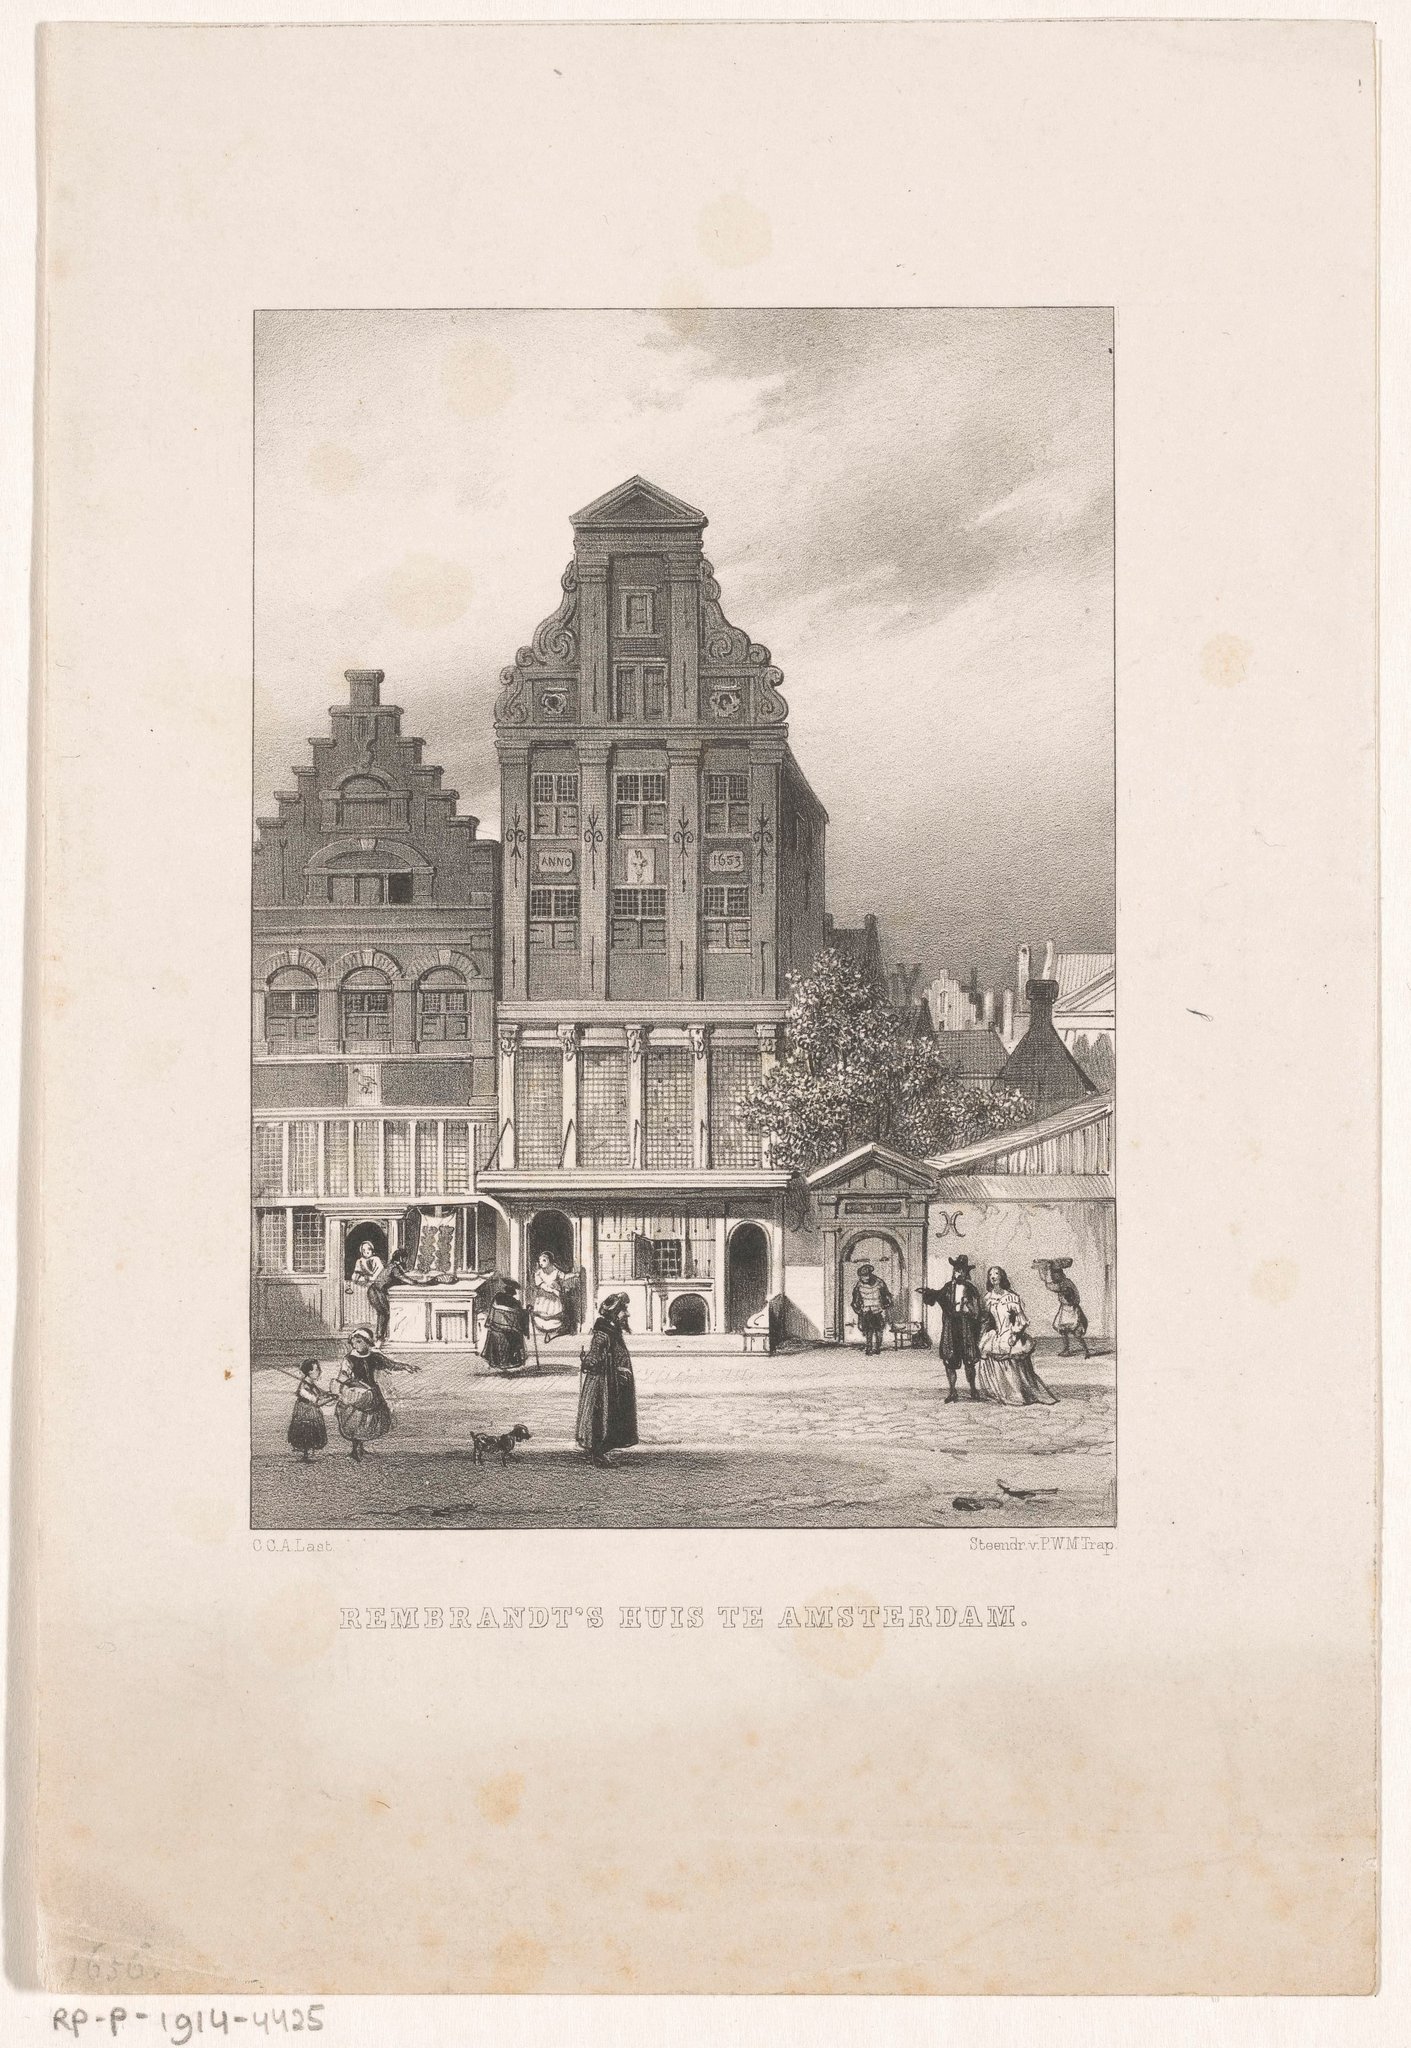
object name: print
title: Rembrandt's Huis te Amsterdam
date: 1836-1876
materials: paper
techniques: lithograph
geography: leiden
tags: amsterdam, painter, print maker, draughtsman, rembrandt van rijn, urban housing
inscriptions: collector's mark: Lugt 2228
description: Mogelijk het Rembrandthuis voor de verbouwing in 1827/1828. Het pand lag aan de toenmalige Sint-Anthonisbreestraat 60, de huidige Jodenbreestraat in Amsterdam.